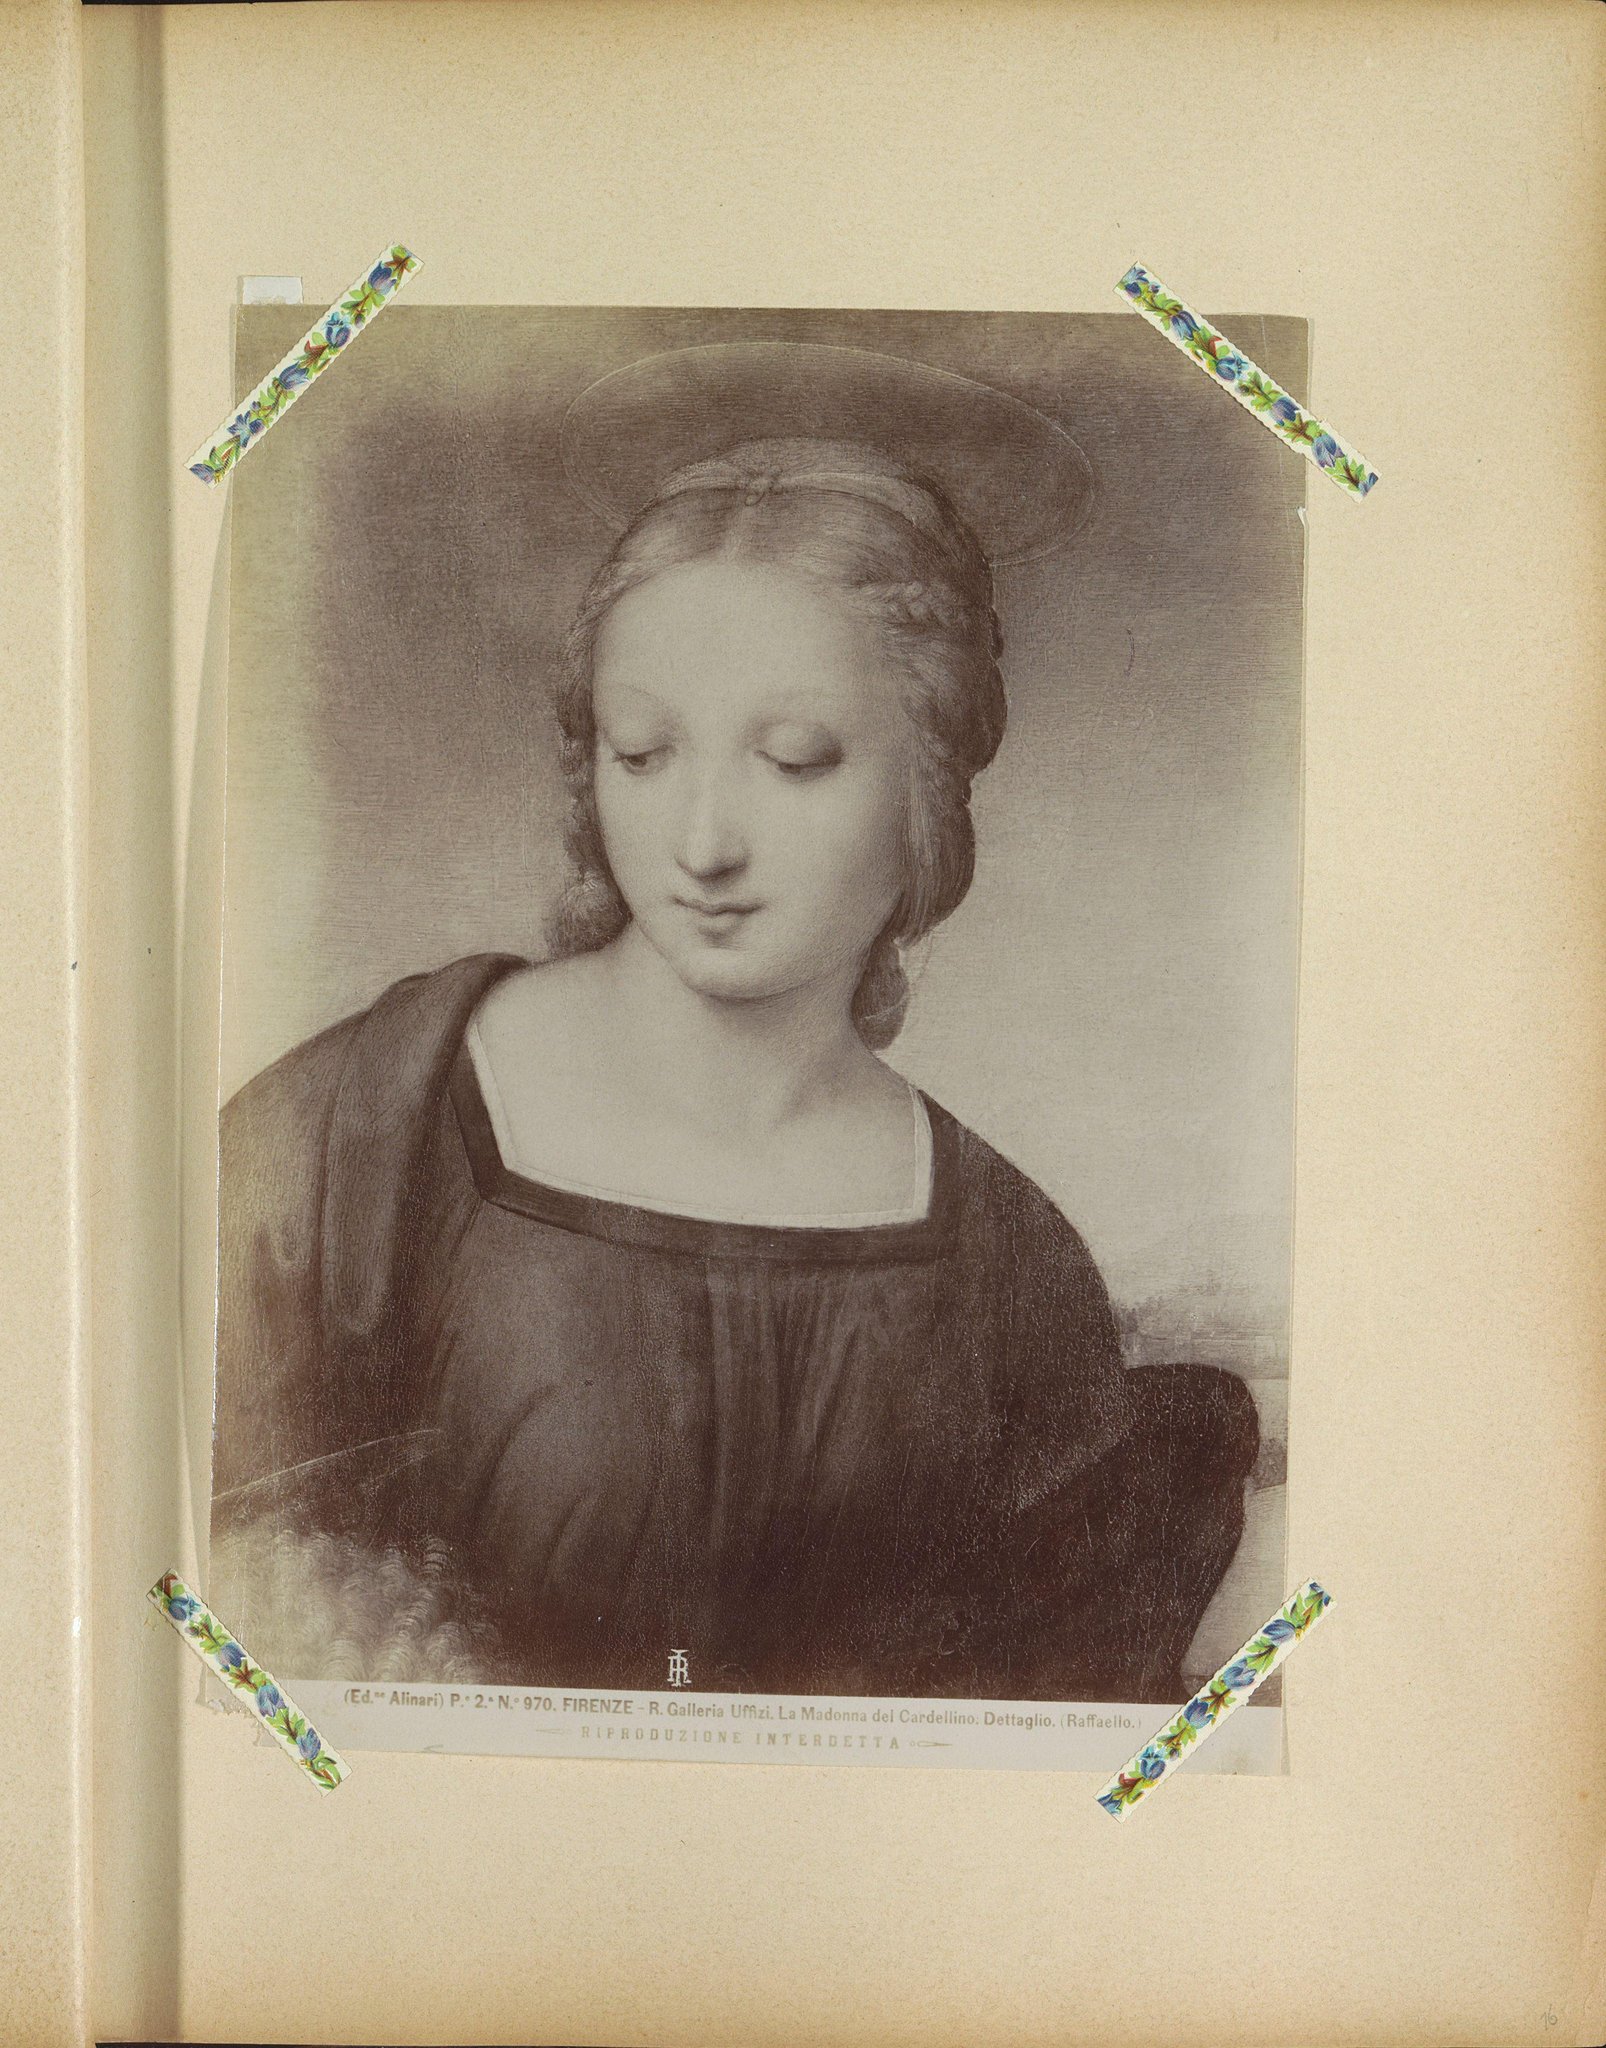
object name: reproduction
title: Firenze - R. Galleria Uffizi. La Madonna del Cardellino. Dettaglio. (Rafaello)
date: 1860-1900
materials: photographic support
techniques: albumen print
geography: florence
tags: madonna: i.e. mary with the christ-child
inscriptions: number: ‘P.e.2.a No. 970’, inscription: ‘IR’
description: Onderdeel van Fotoalbum met opnames van bezienswaardigheden in Italiaanse steden en van kunstwerken.